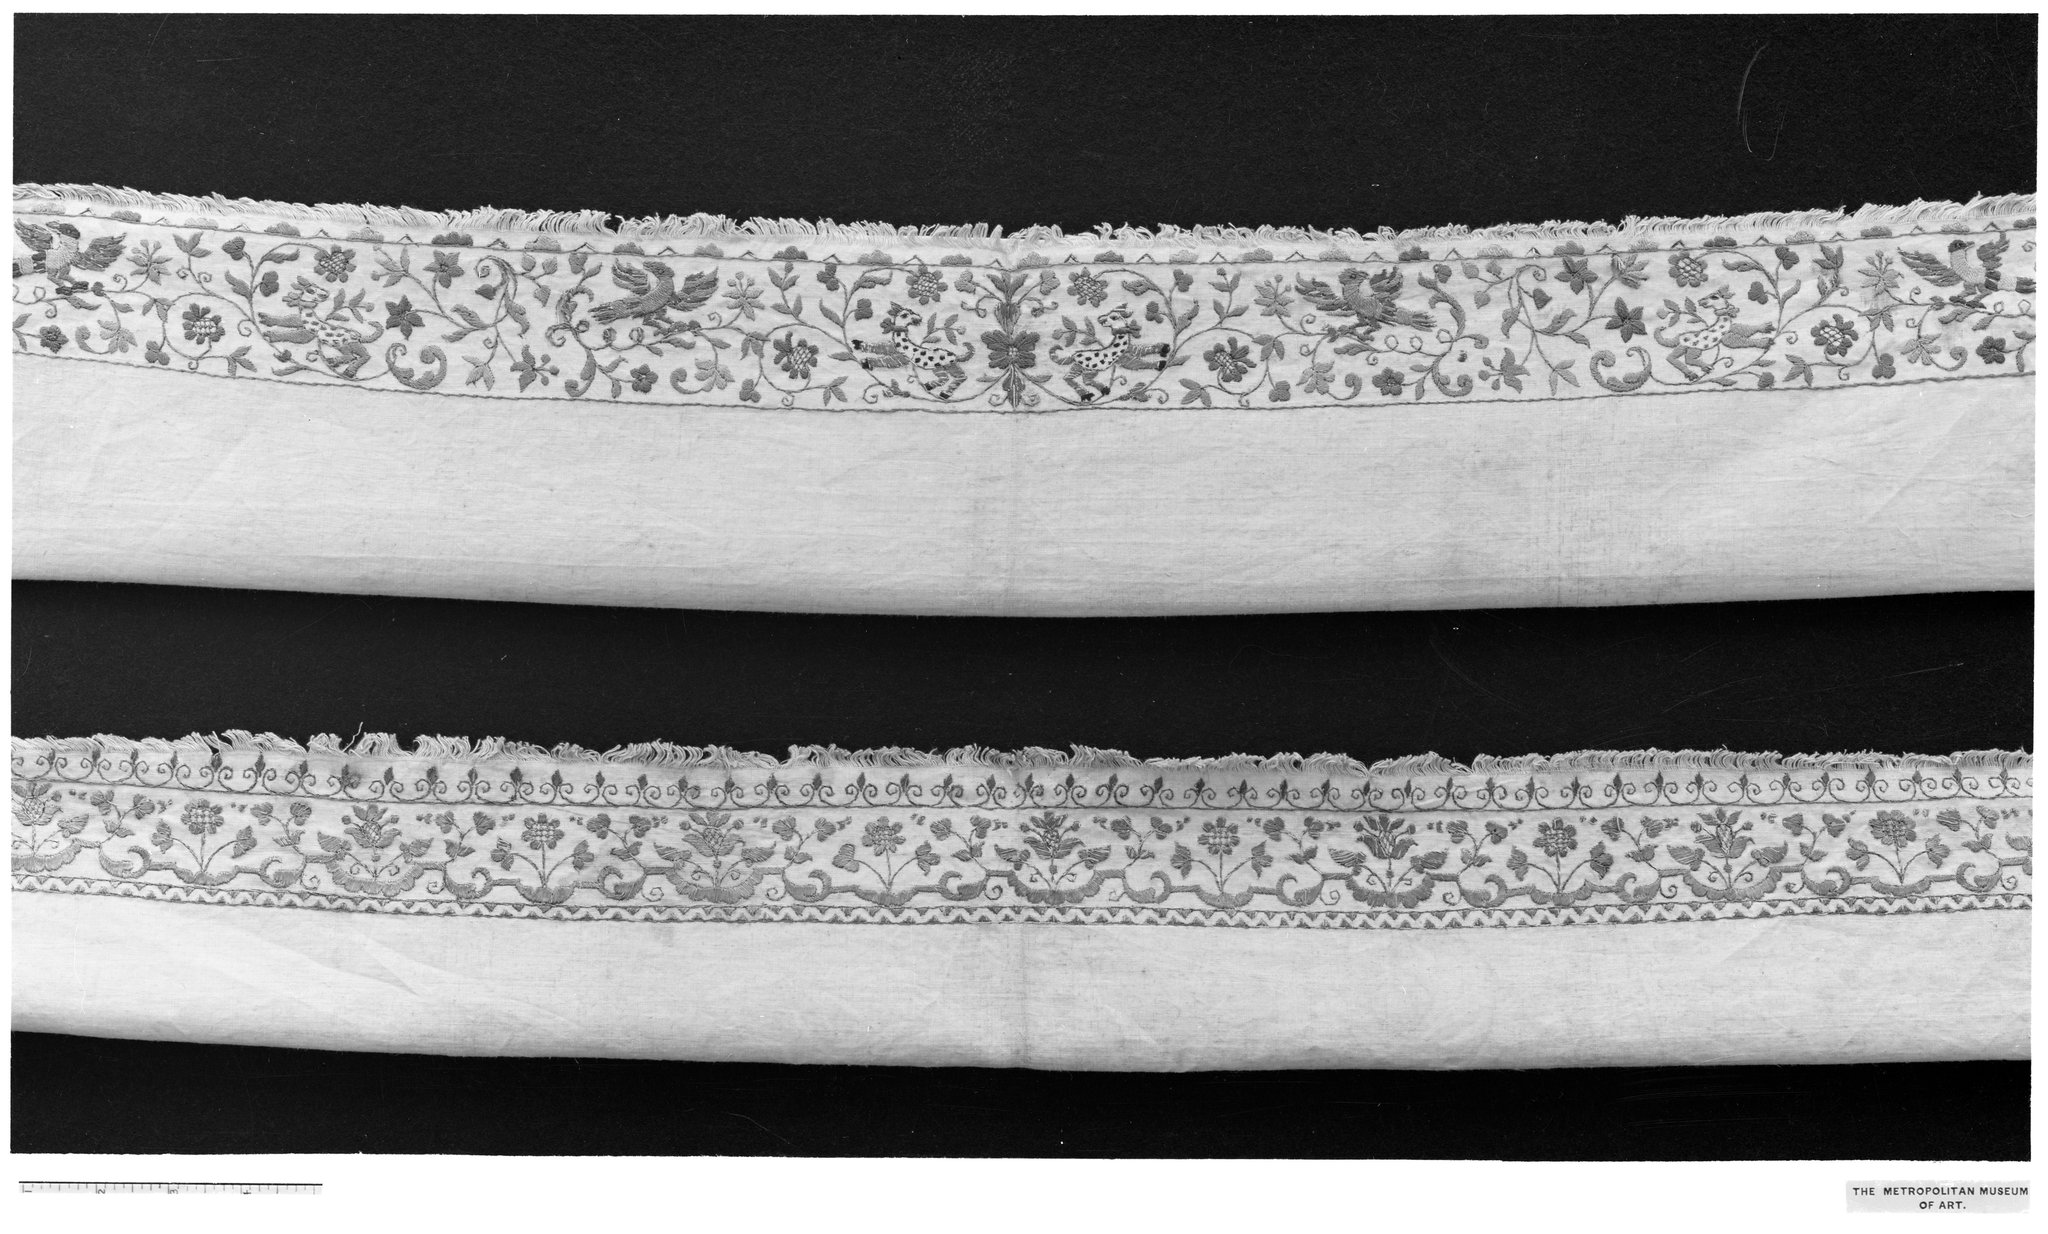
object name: towel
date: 1501-1600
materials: linen, metal thread, silk